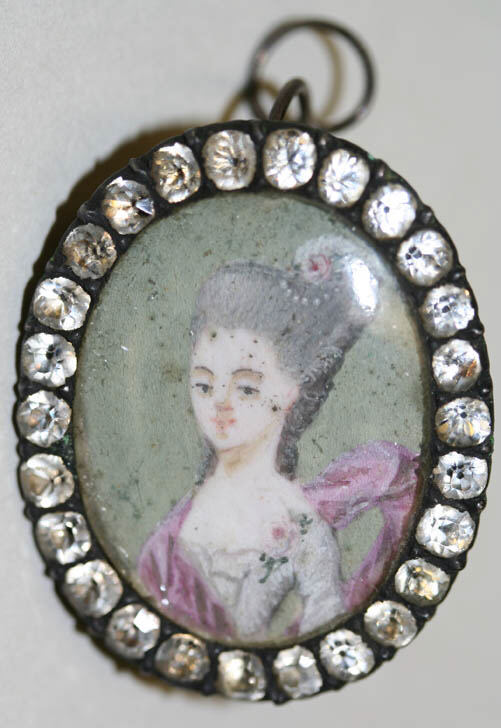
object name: earring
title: Earrings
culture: french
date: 1701-1800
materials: metal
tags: portraits,women